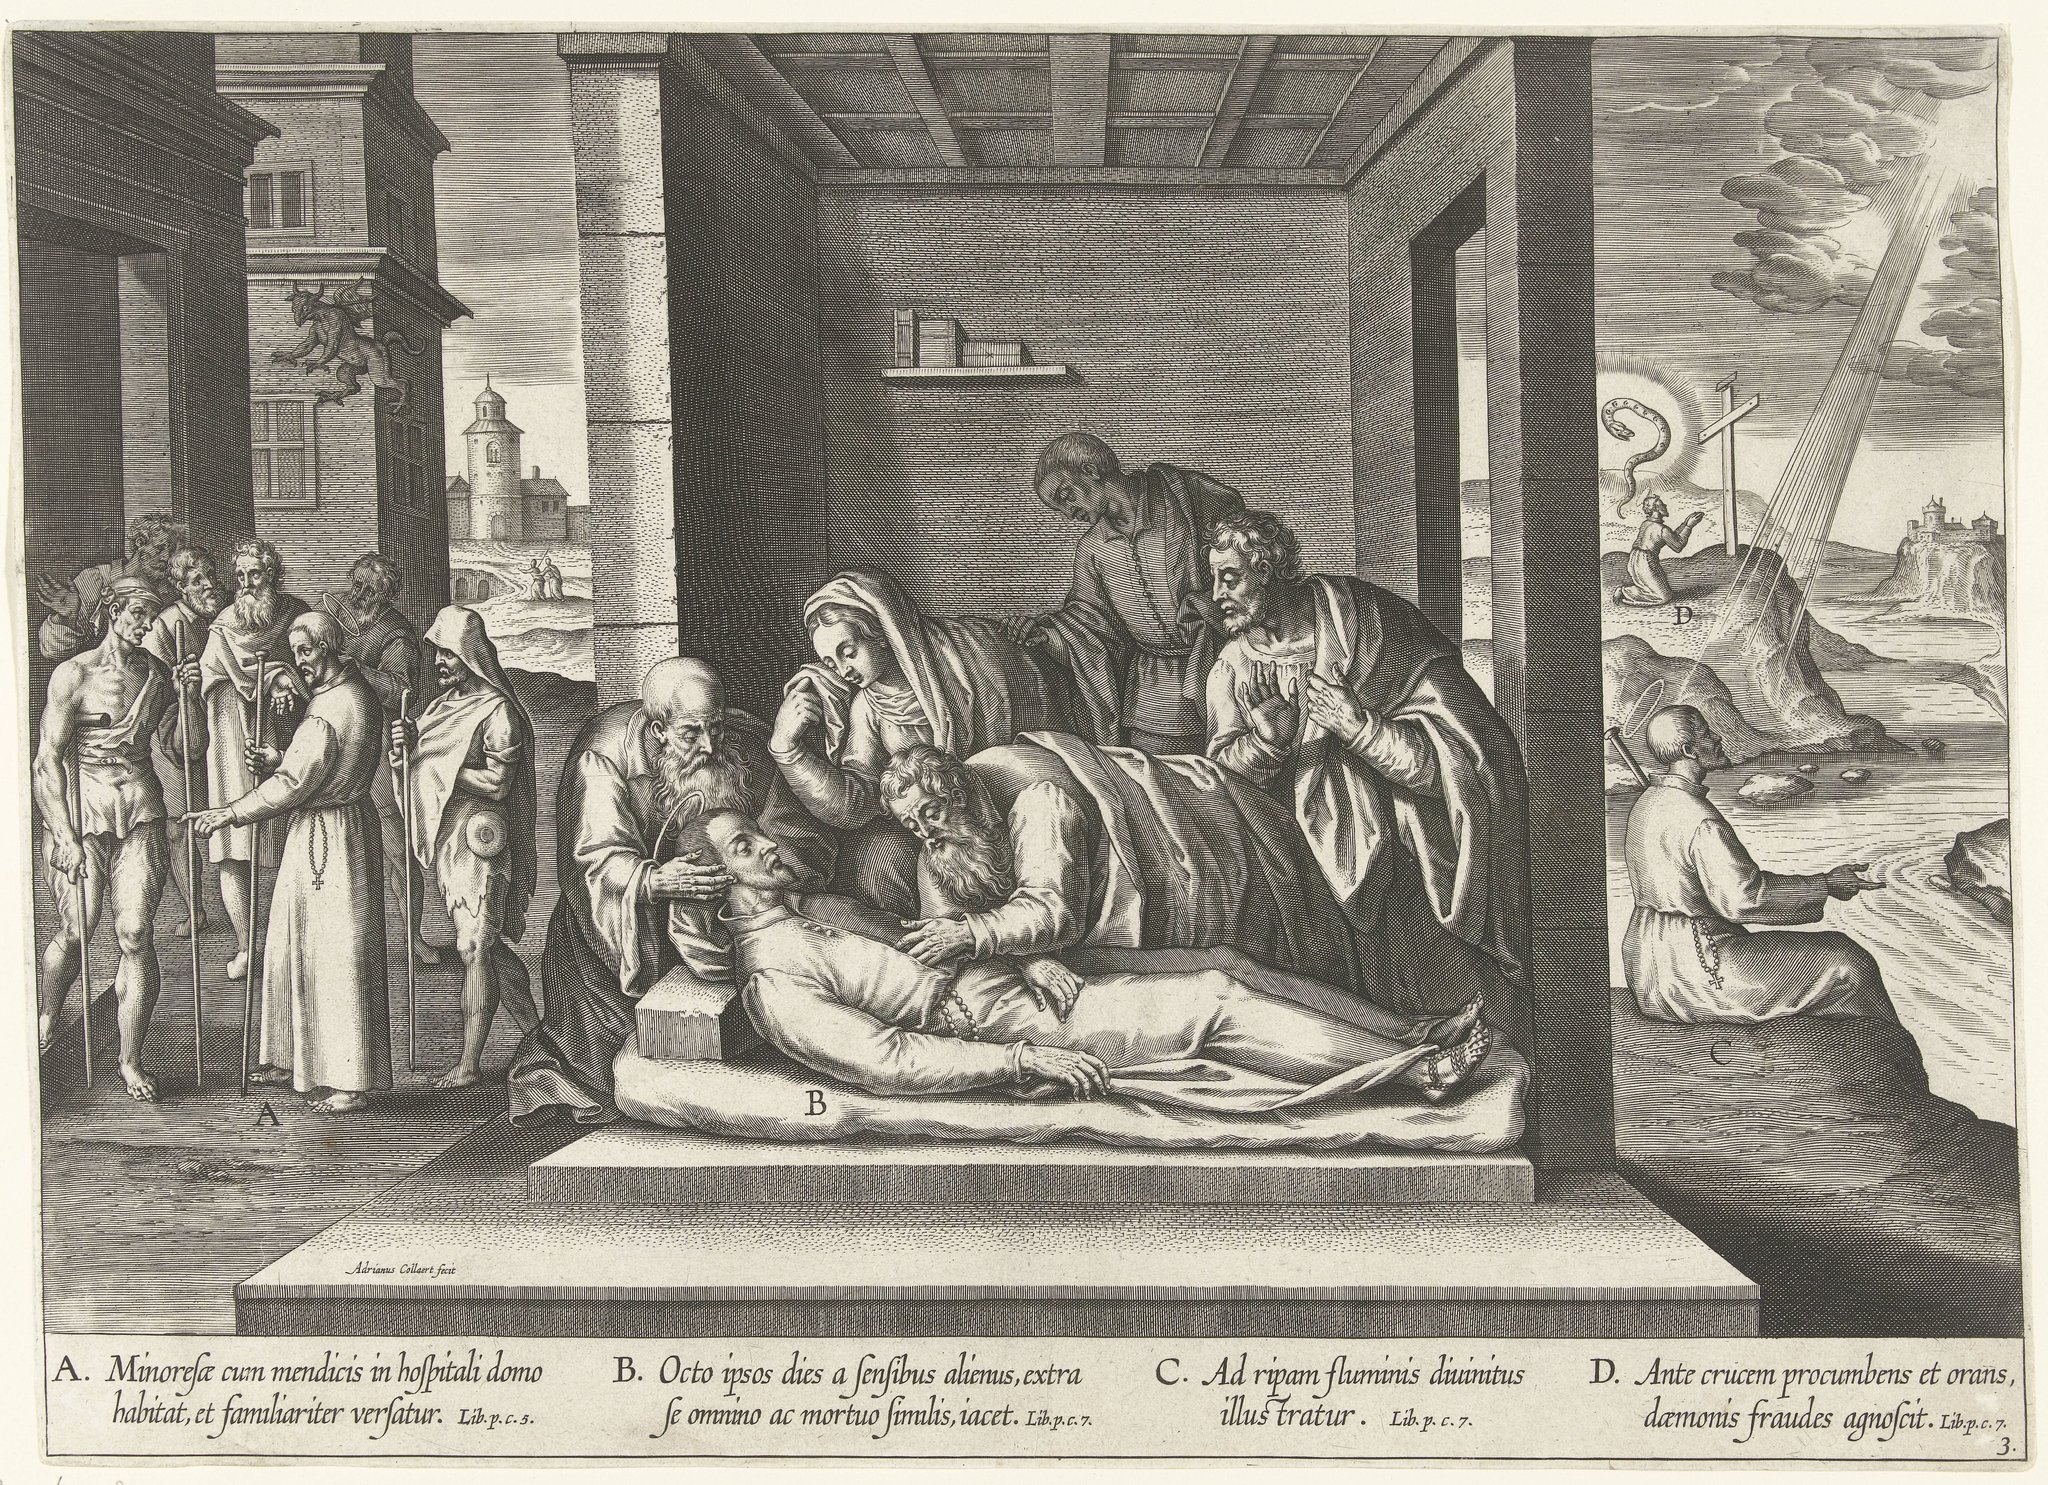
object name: print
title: Ignatius in Manresa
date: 1610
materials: paper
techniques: engraving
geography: antwerp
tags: personal devotion of st. ignatius of loyola - male saint meditating, in ecstasy, personal devotion of st. ignatius of loyola - temptation of male saint, personal devotion of st. ignatius of loyola - renouncing worldly goods, ascetic life of male saint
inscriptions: collector's mark: Lugt 2760, collector's mark: Lugt 2228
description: Vier scènes uit het leven van Ignatius van Loyola. Ignatius verblijft een tijd in Manresa. Centraal Ignatius de Loyola die door hoge koorts is geveld. Hij wordt verzorgd door zijn volgelingen. Links Loyola in het gasthuis, waar hij samen met bedelaars om aalmoezen vroeg. Rechts bidt Loyola voor een kruisbeeld en het visioen van een slang. Deze slang blijkt een vals visioen van de duivel te zijn. Rechtsonder krijgt Loyola een visioen van God op de oever van een rivier. De prent heeft Latijnse onderschriften met verwijzingen naar de scènes in de prent. De prent is deel van een vijftiendelige serie over het leven van Ignatius van Loyola.